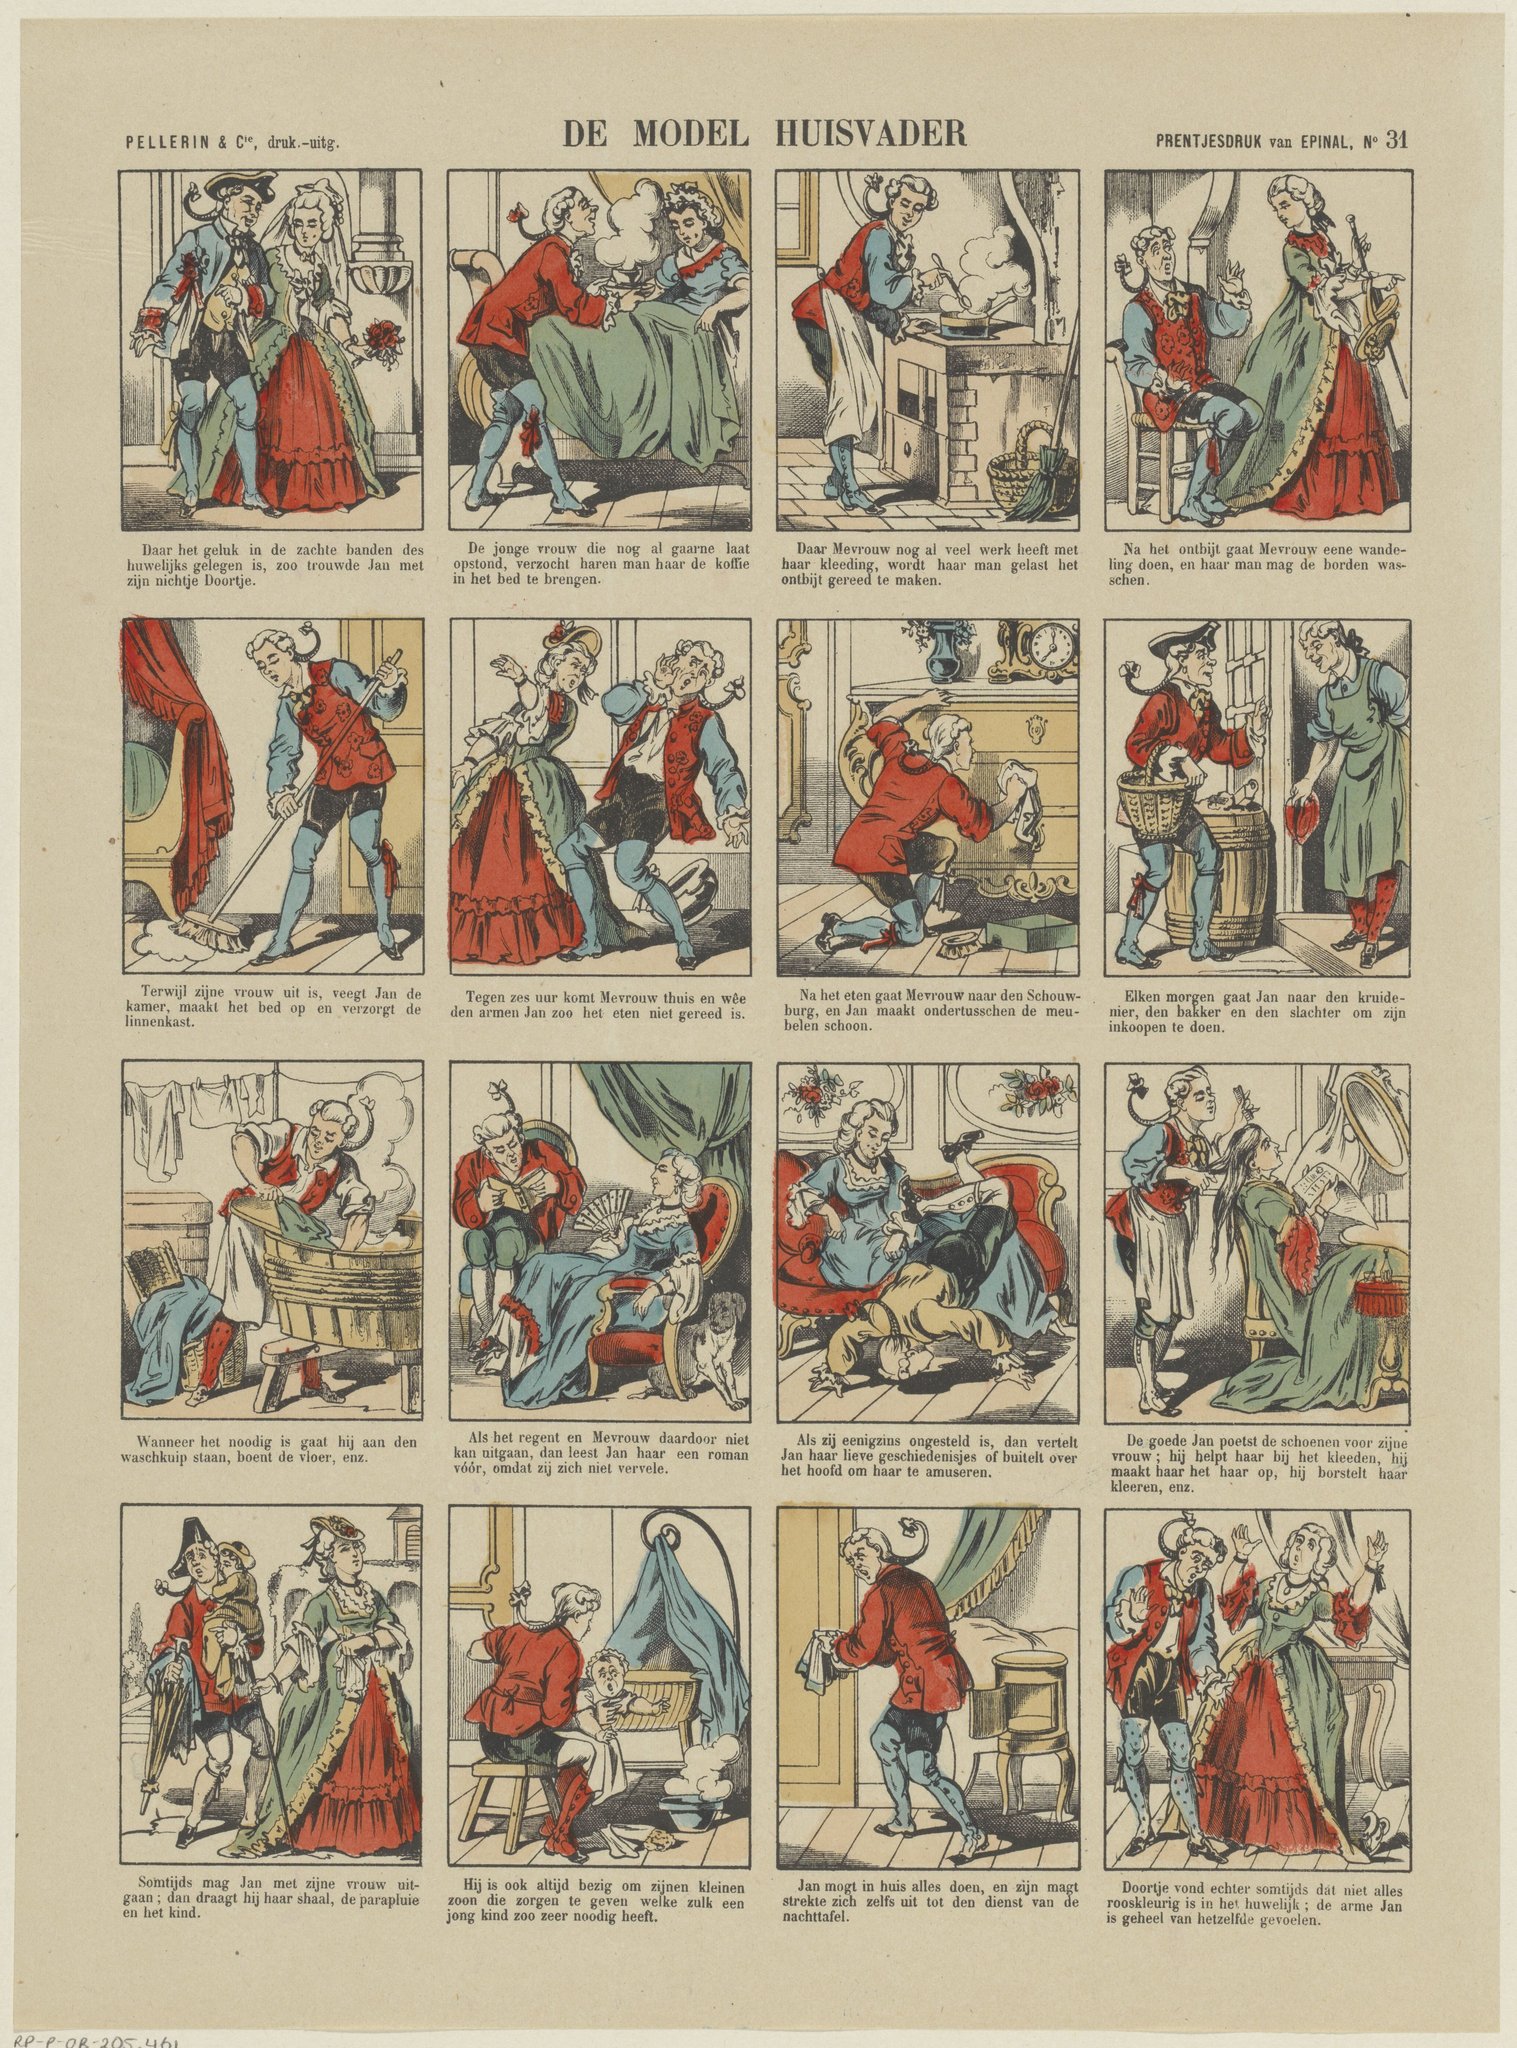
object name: print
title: De nieuwe Jan de Wasscher (The New John the Washerman)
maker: Anonymous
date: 1902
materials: paper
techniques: colour, letterpress printing, lithograph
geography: epinal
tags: hen-pecked husband, 'betty', 'molly' (man who engages in women's work)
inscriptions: collector's mark: Lugt 2760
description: Blad met 16 voorstellingen van een man die van zijn vrouw, die de broek aan heeft, al het huishoudelijk werk moet doen. Onder elke afbeelding een onderschrift. Genummerd rechtsboven: No 31.